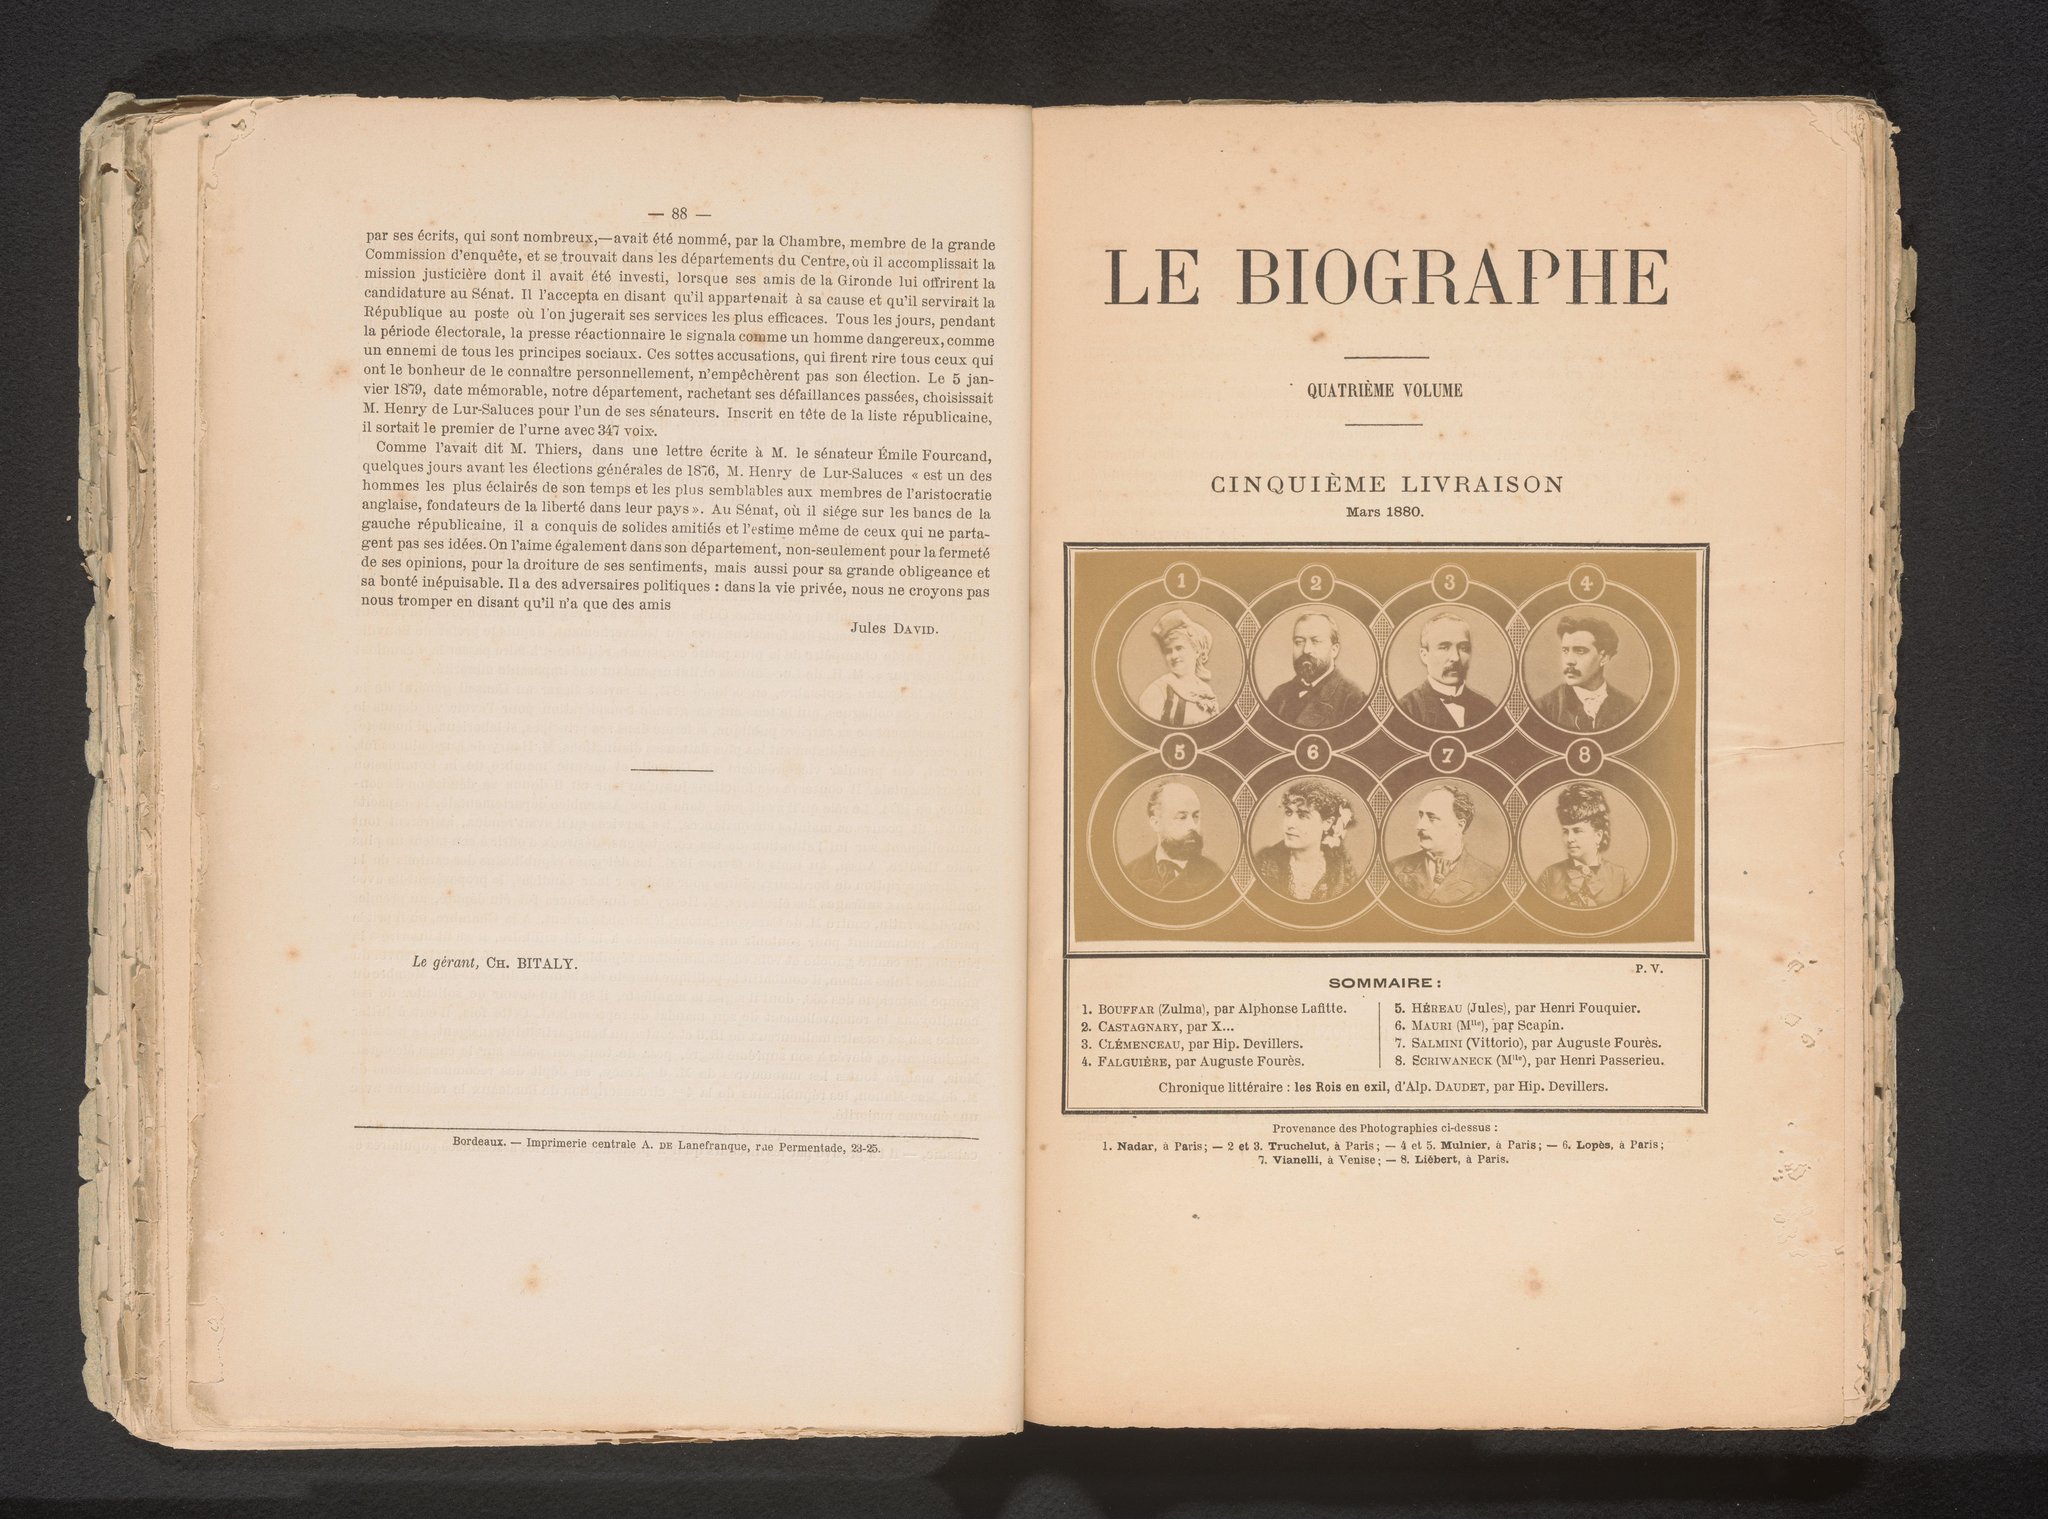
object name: page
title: Samengesteld groepsportret van acht beroemdheden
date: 1875-1880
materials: photographic support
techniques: albumen print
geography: paris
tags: print maker, sculptor, alexandre falguière, painter, historical persons not known by name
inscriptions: inscription: ‘Sommaire: (...) Hip. Devillers’, number: ‘1 (...) 8’